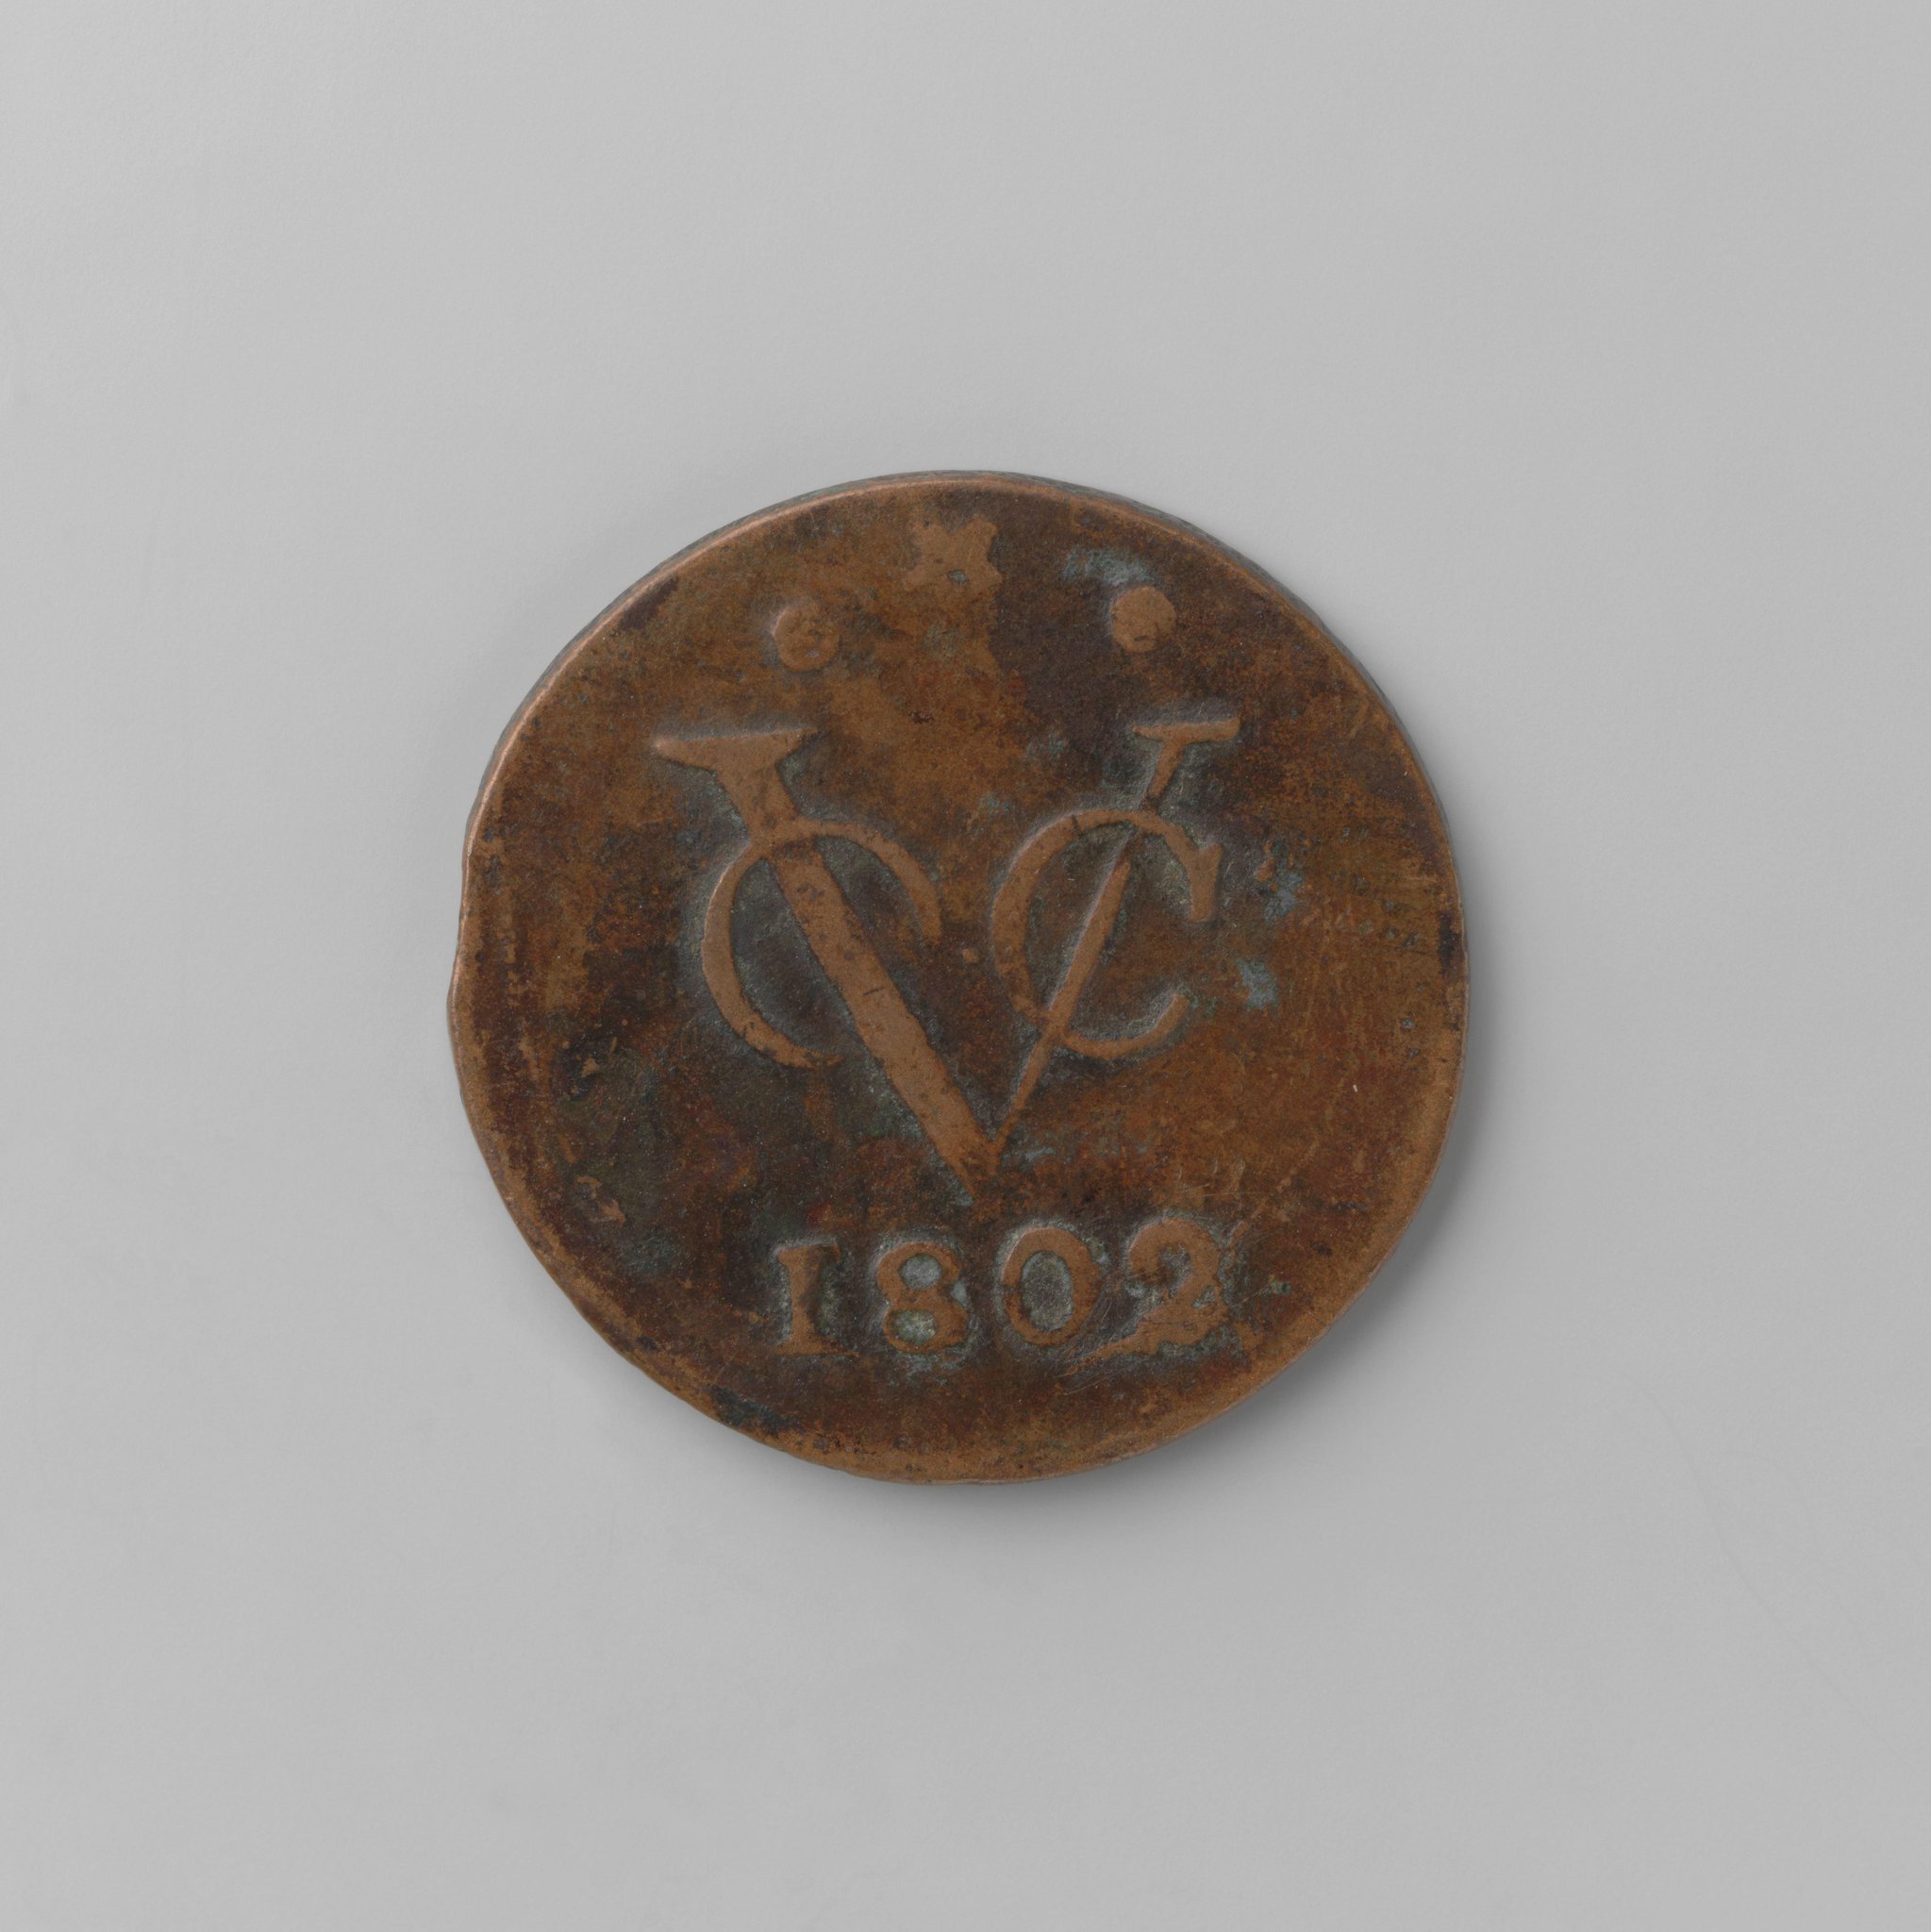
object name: coin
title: Duit voor Nederlands Indië uit Holland,1802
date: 1802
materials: copper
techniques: striking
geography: enkhuizen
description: Koperen munt. Voorzijde: gekroond wapenschild van Holland. Keerzijde: monogram van de VOC, waarboven muntteken ster en waaronder jaartal. Gladde rand.